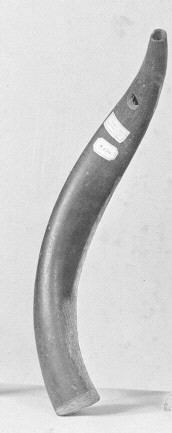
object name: horn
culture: african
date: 1867-1900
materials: horn